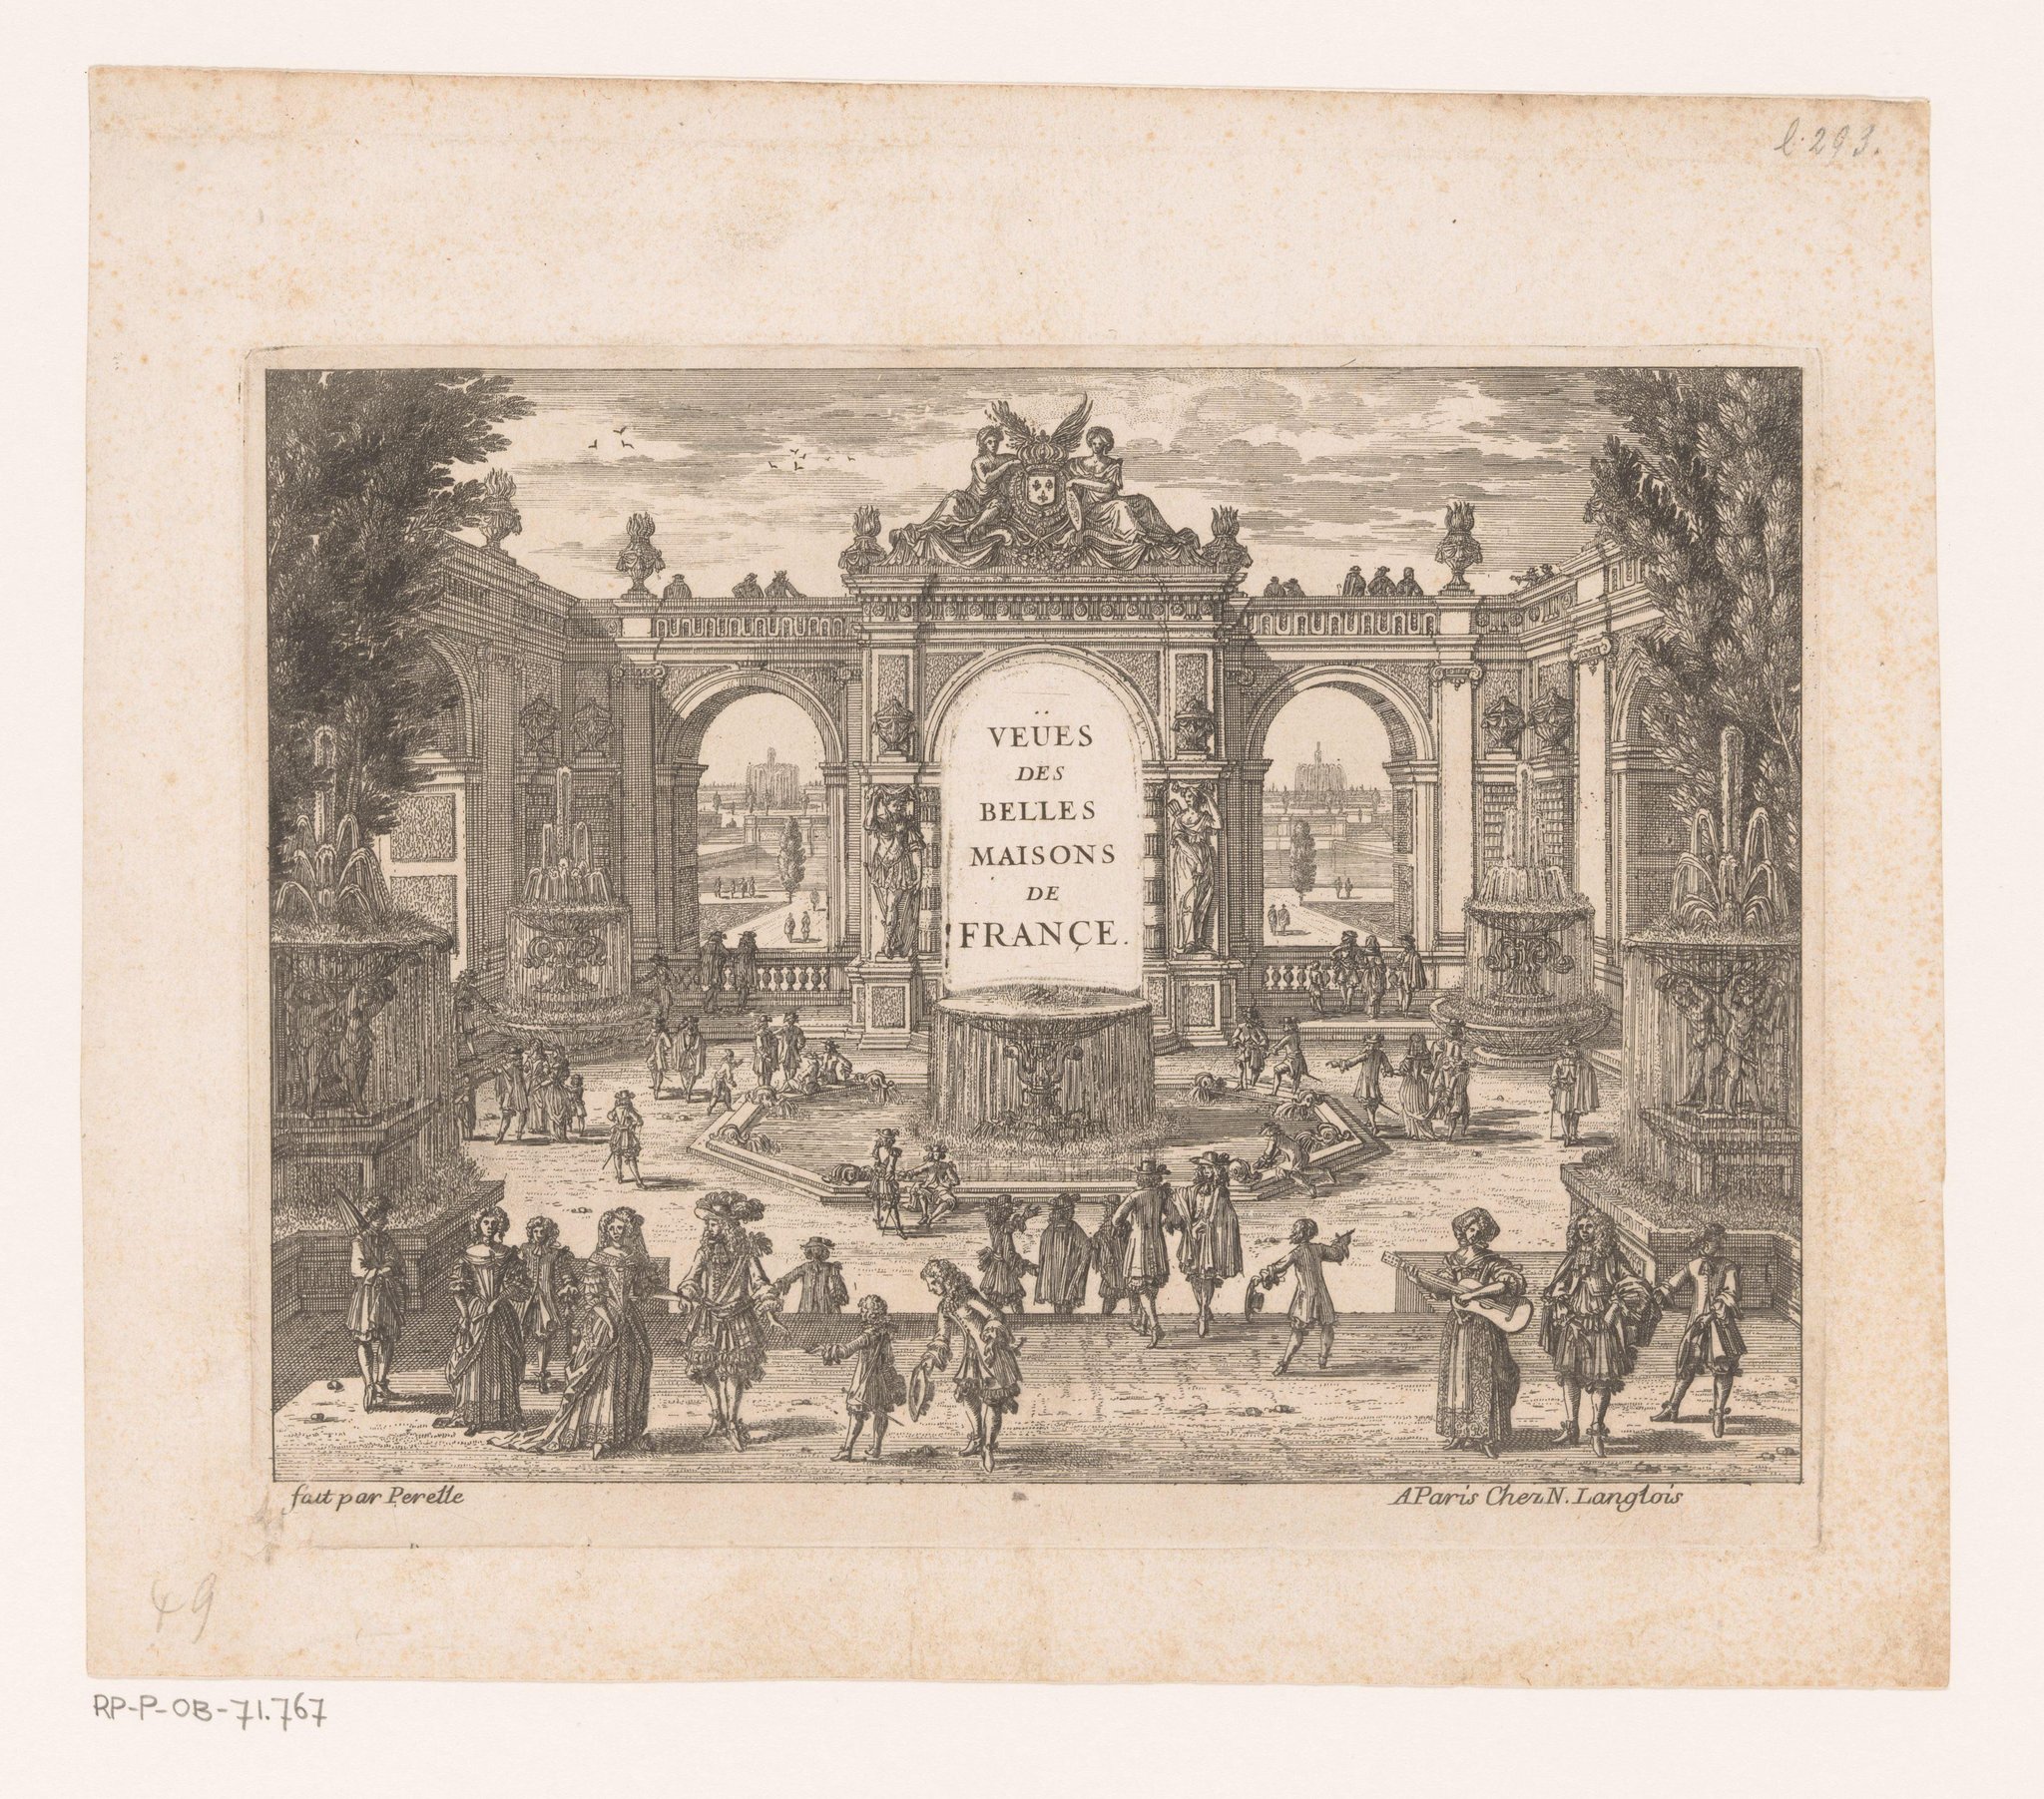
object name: titelprent, frontispice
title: Veues des belles Maisons de France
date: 1650-1677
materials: paper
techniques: etching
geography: paris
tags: courtyard, ornamental fountain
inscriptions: collector's mark: Lugt 2228